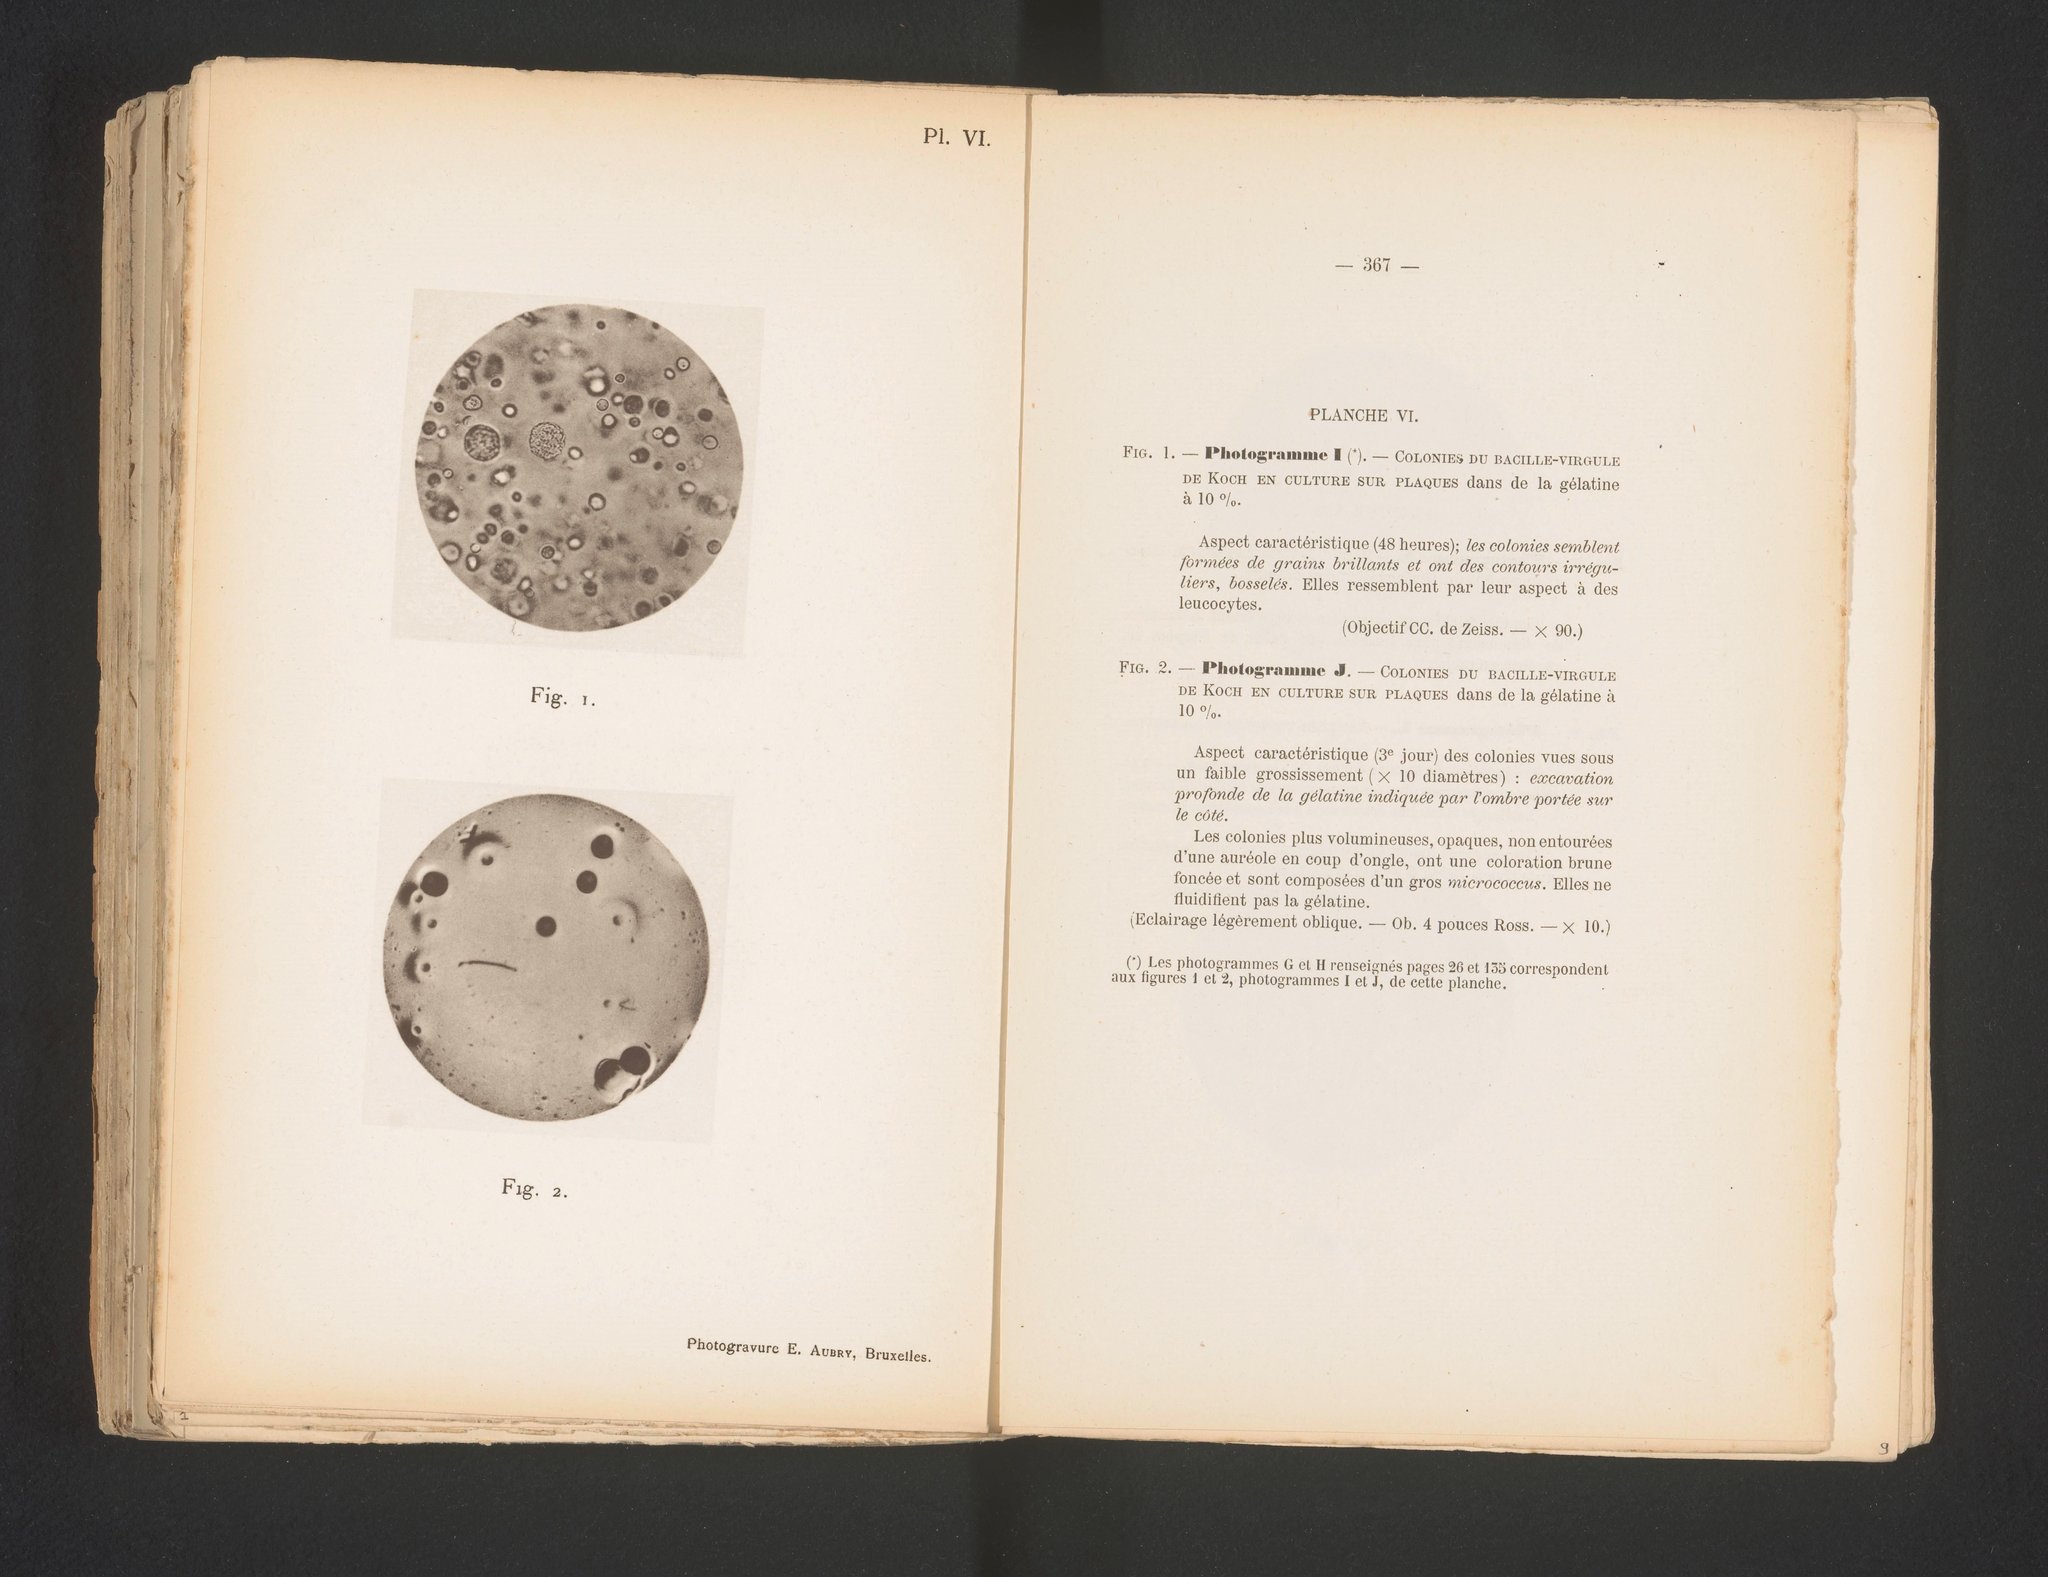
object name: page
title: Twee microscoopopnamen van cholera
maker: émile van ermengem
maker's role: bioloog, fotograaf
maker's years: 1851-1932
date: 1875-1885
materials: paper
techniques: photograph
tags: diseases affecting the whole body, microscope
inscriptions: inscription: ‘Fig. 1.- Photogramme I (*). Colonies du bacille-virgule de Koch en culture sur plaques dans de la gélatine à 10 % (...) Fig. 2. - Photogramme J.- Colonies du bacille-virgule de Koch en culture sur plaques dans de la gélatine à 10 % (...)’, number: ‘Pl. VI. Fig. 1. Fig. 2.’